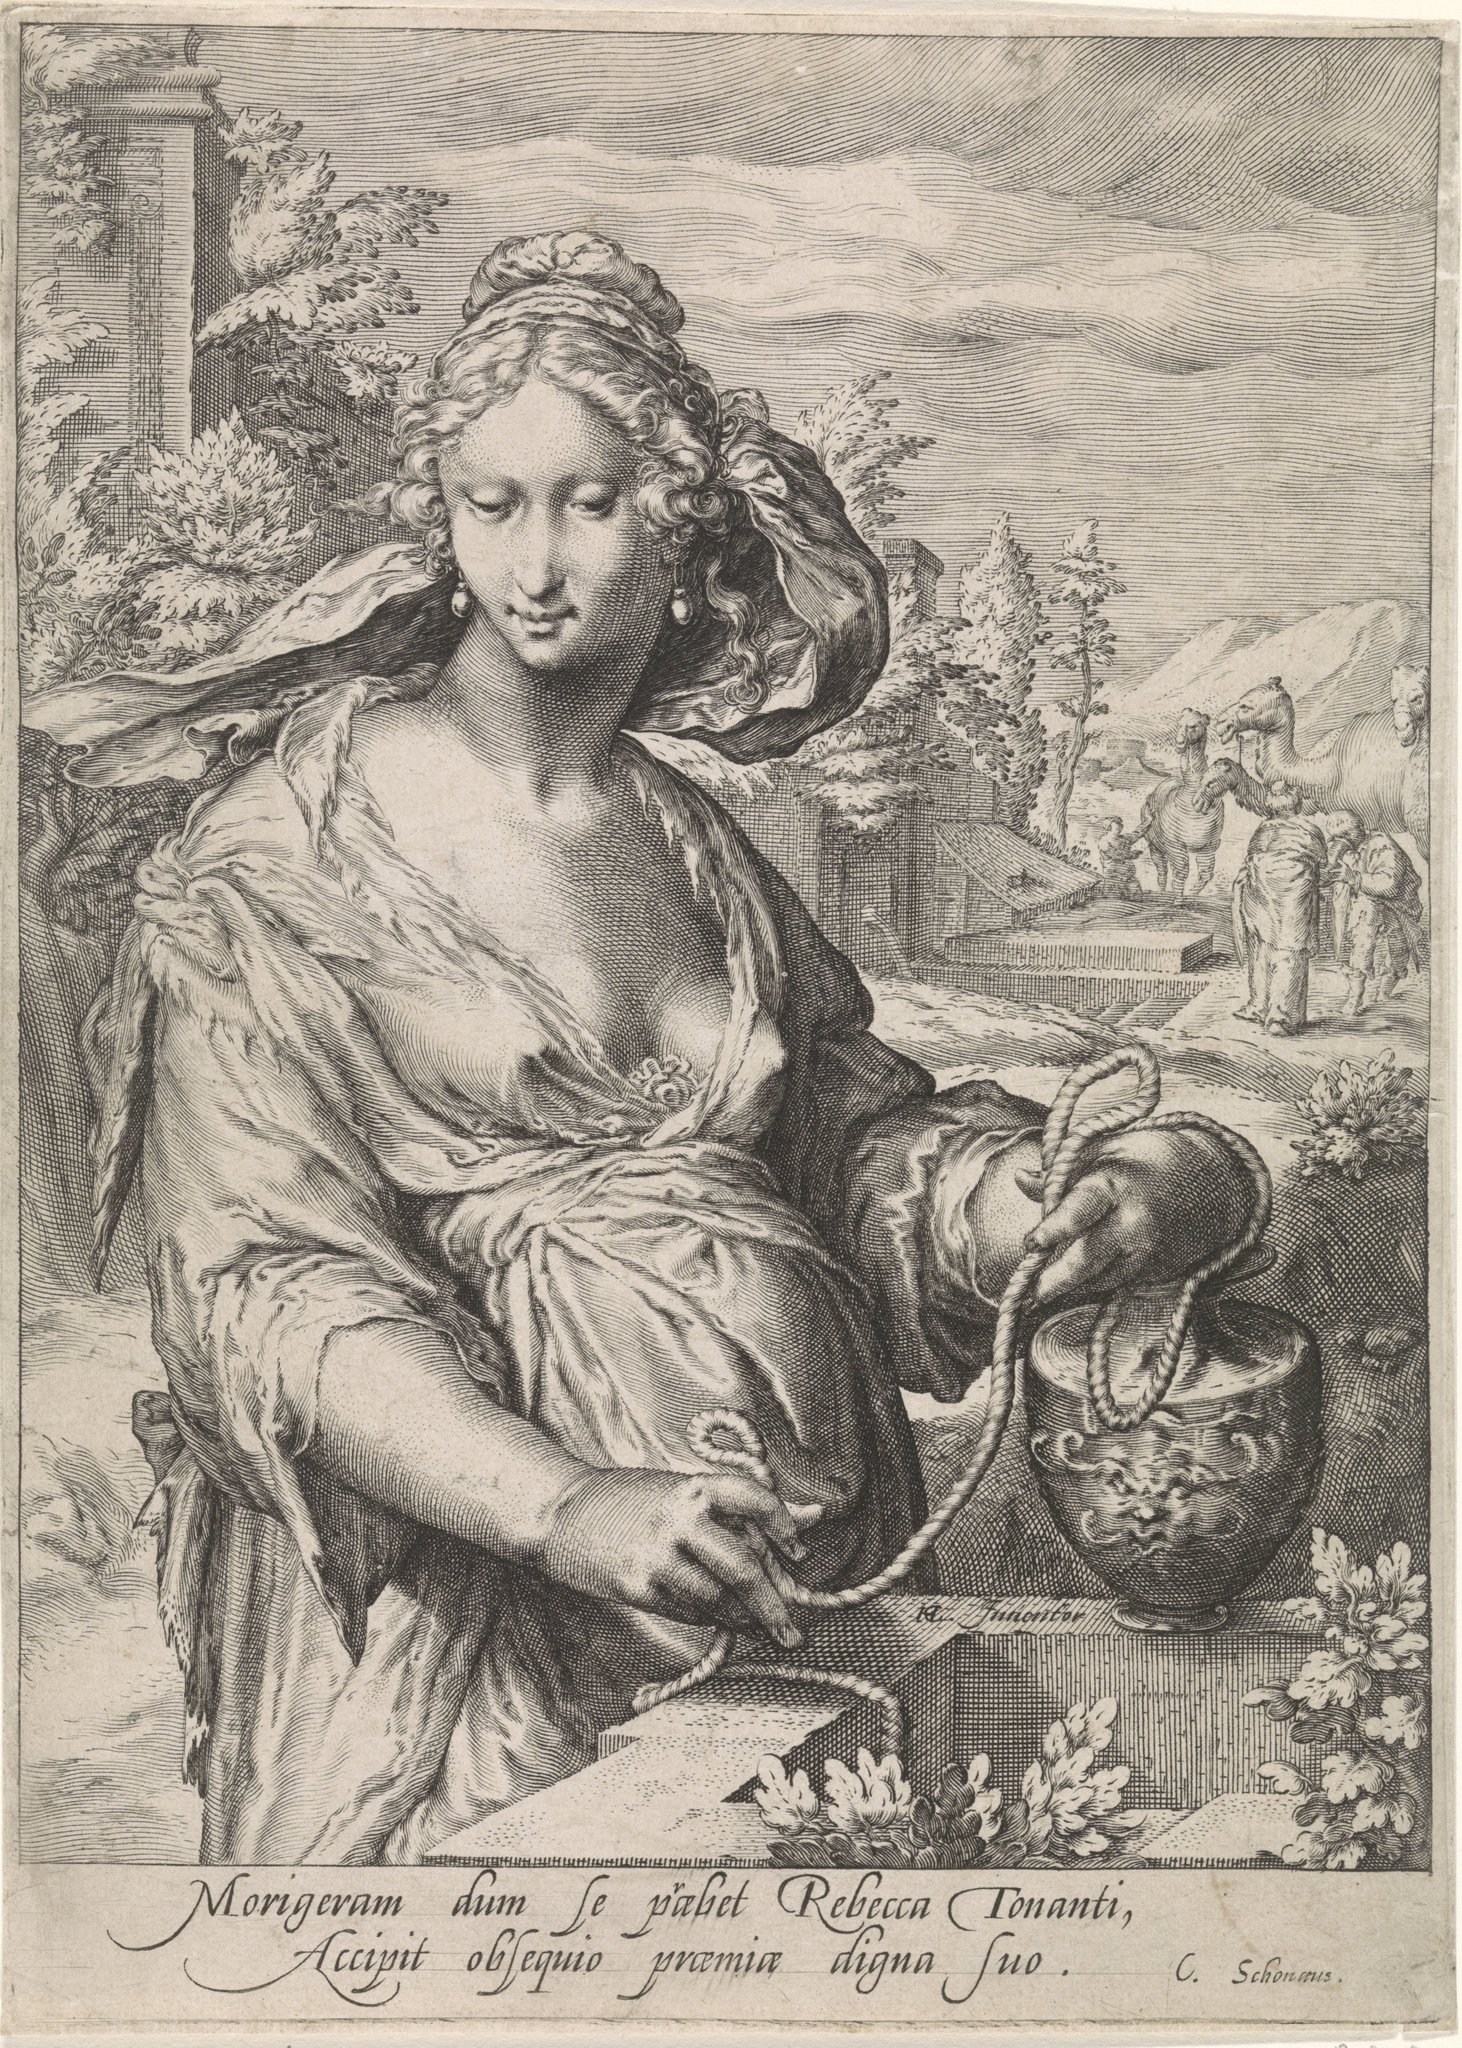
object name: print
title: Rebekka, de vrouw van Isaak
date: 1595-1599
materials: paper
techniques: engraving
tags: rebekah draws water for the camels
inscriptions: collector's mark: Lugt 240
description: Rebekka, de vrouw van de aartsvader Isaak. Op de achtergrond Eliëzer. Prent uit een serie van drie met afbeeldingen van de vrouwen van de drie aartsvaders uit het Oude Testament.